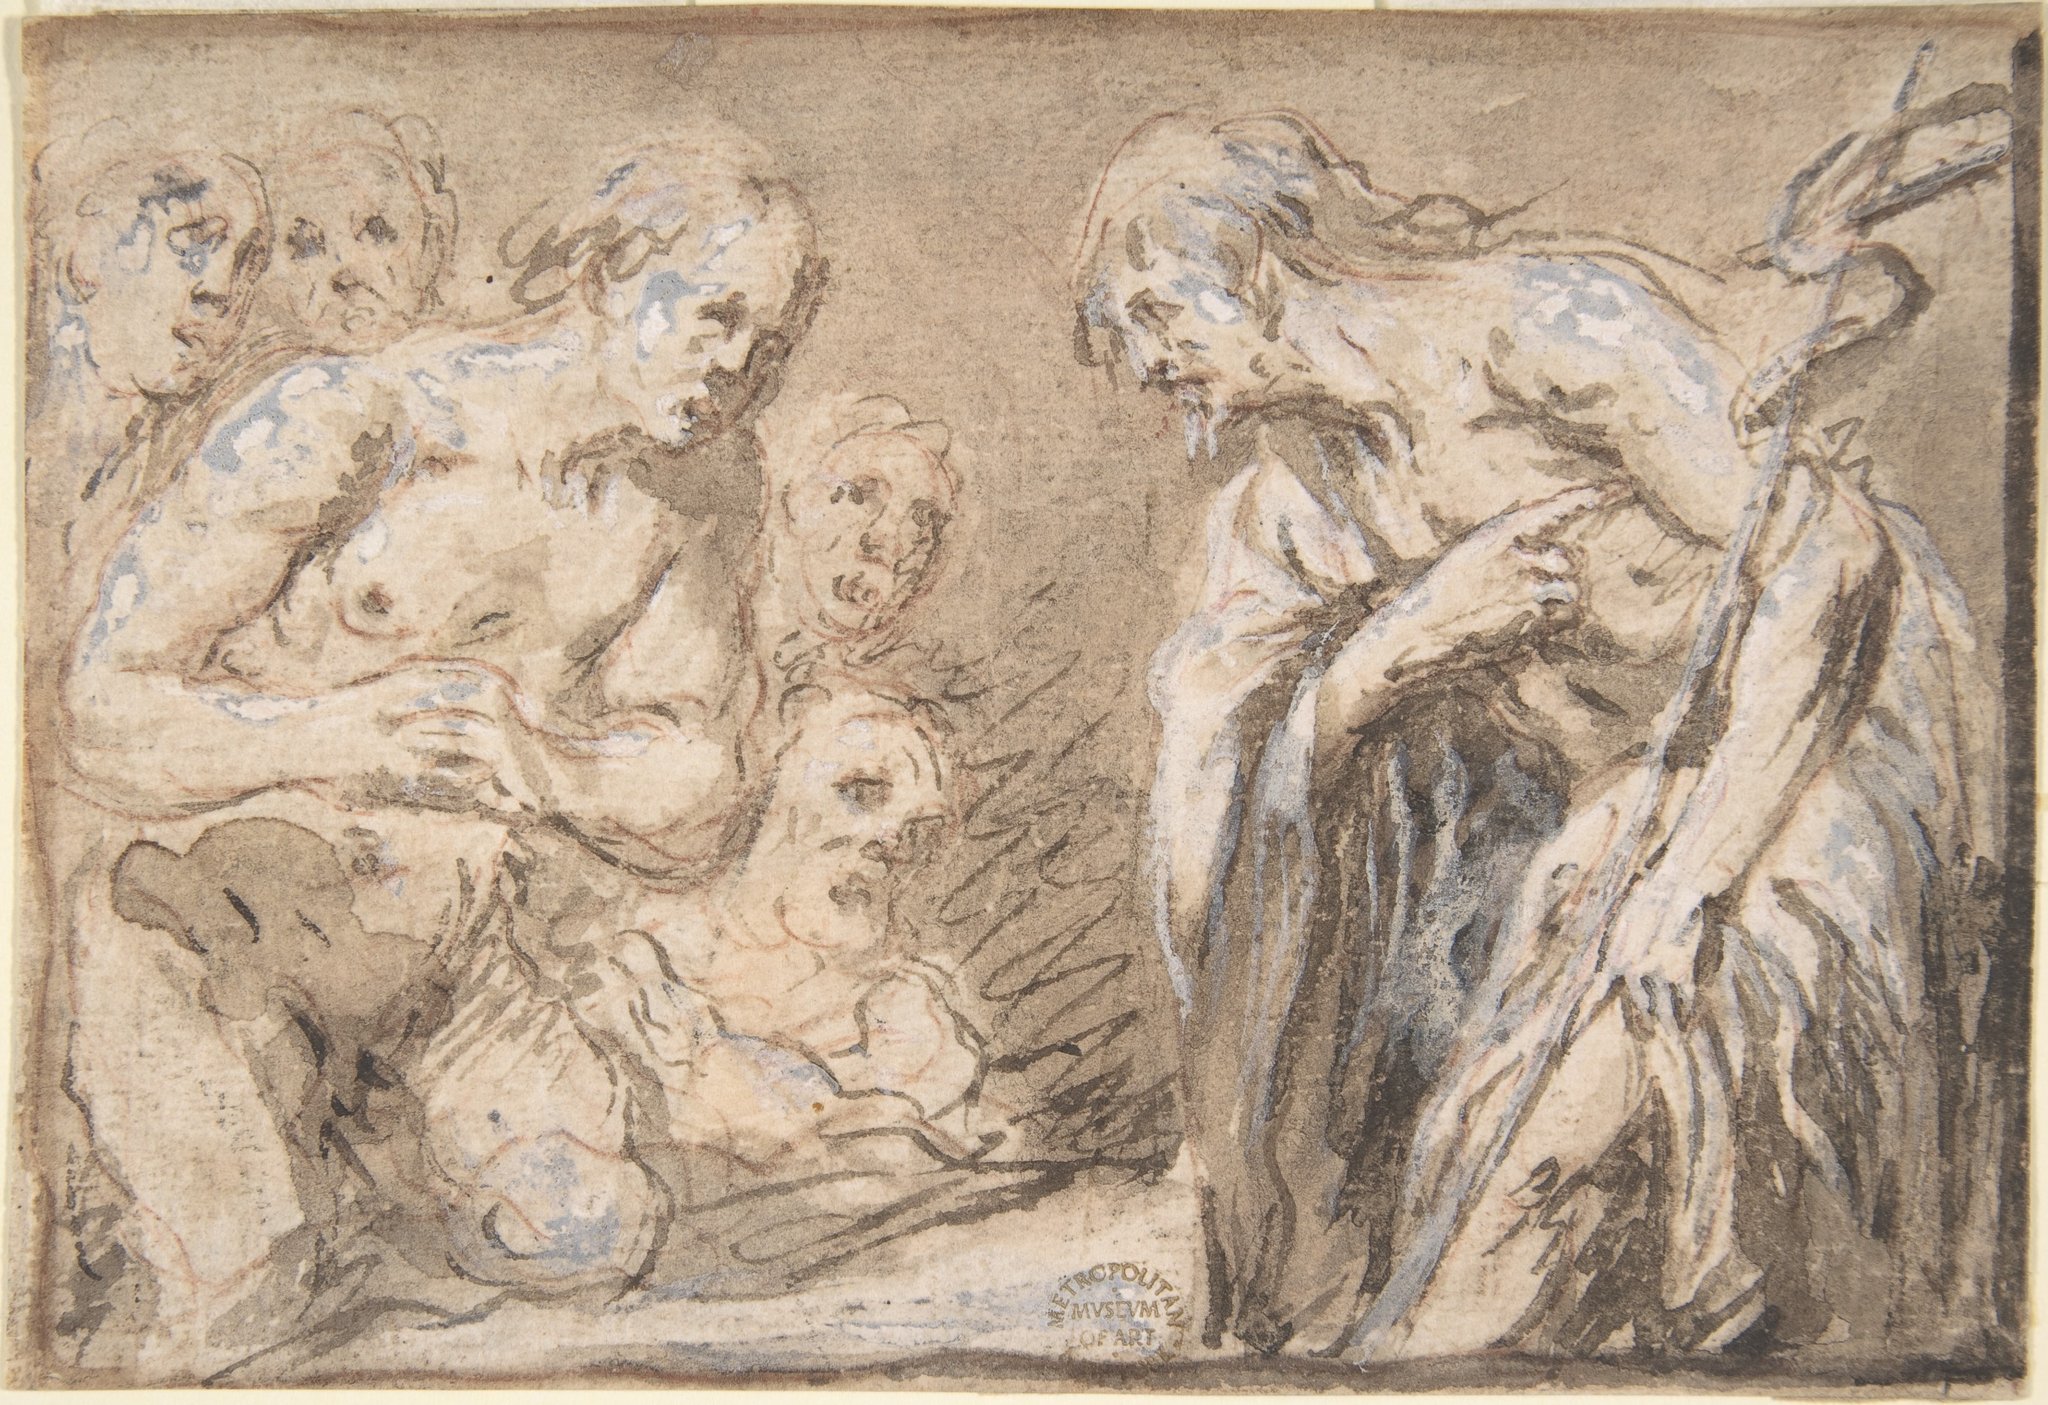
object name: drawing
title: Christ in Limbo (recto); Saint with Rosary (verso)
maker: anonymous, italian, roman-bolognese, 17th century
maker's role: artist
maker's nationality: italian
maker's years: 1600-1700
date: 1601-1700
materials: chalk, gouache, ink, paper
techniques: brush, highlighting, pen, wash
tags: christ,saints